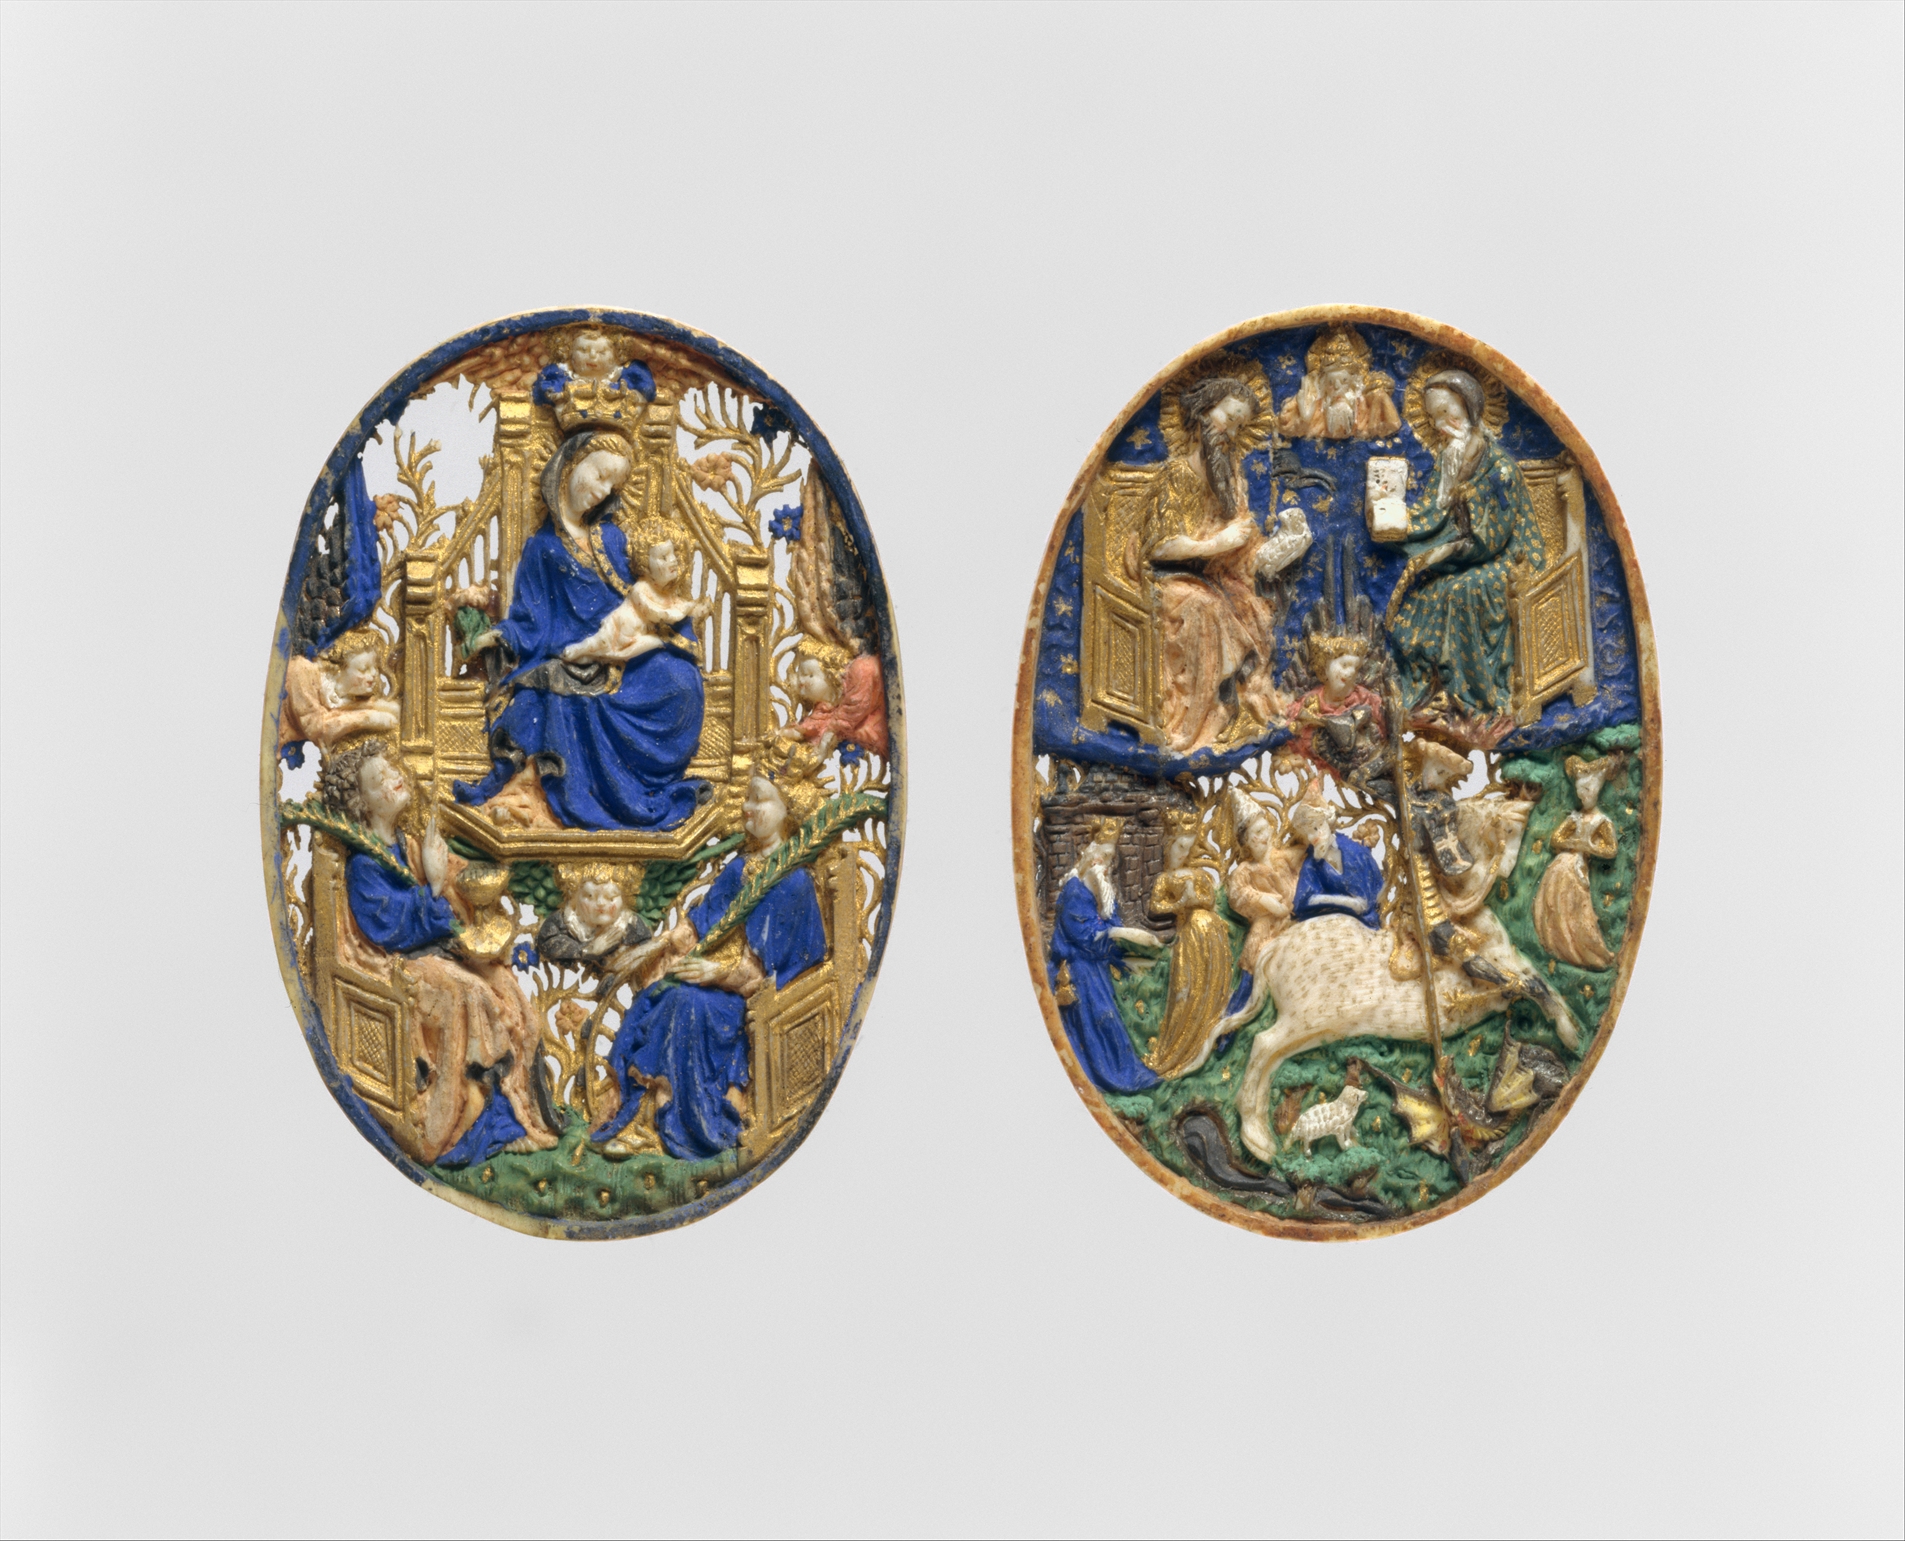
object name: reliquary locket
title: Two Medallions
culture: french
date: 1420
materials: ivory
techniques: gilding, polychromy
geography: france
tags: horses,madonna and child,saint john the baptist,saint john the evangelist,god the father